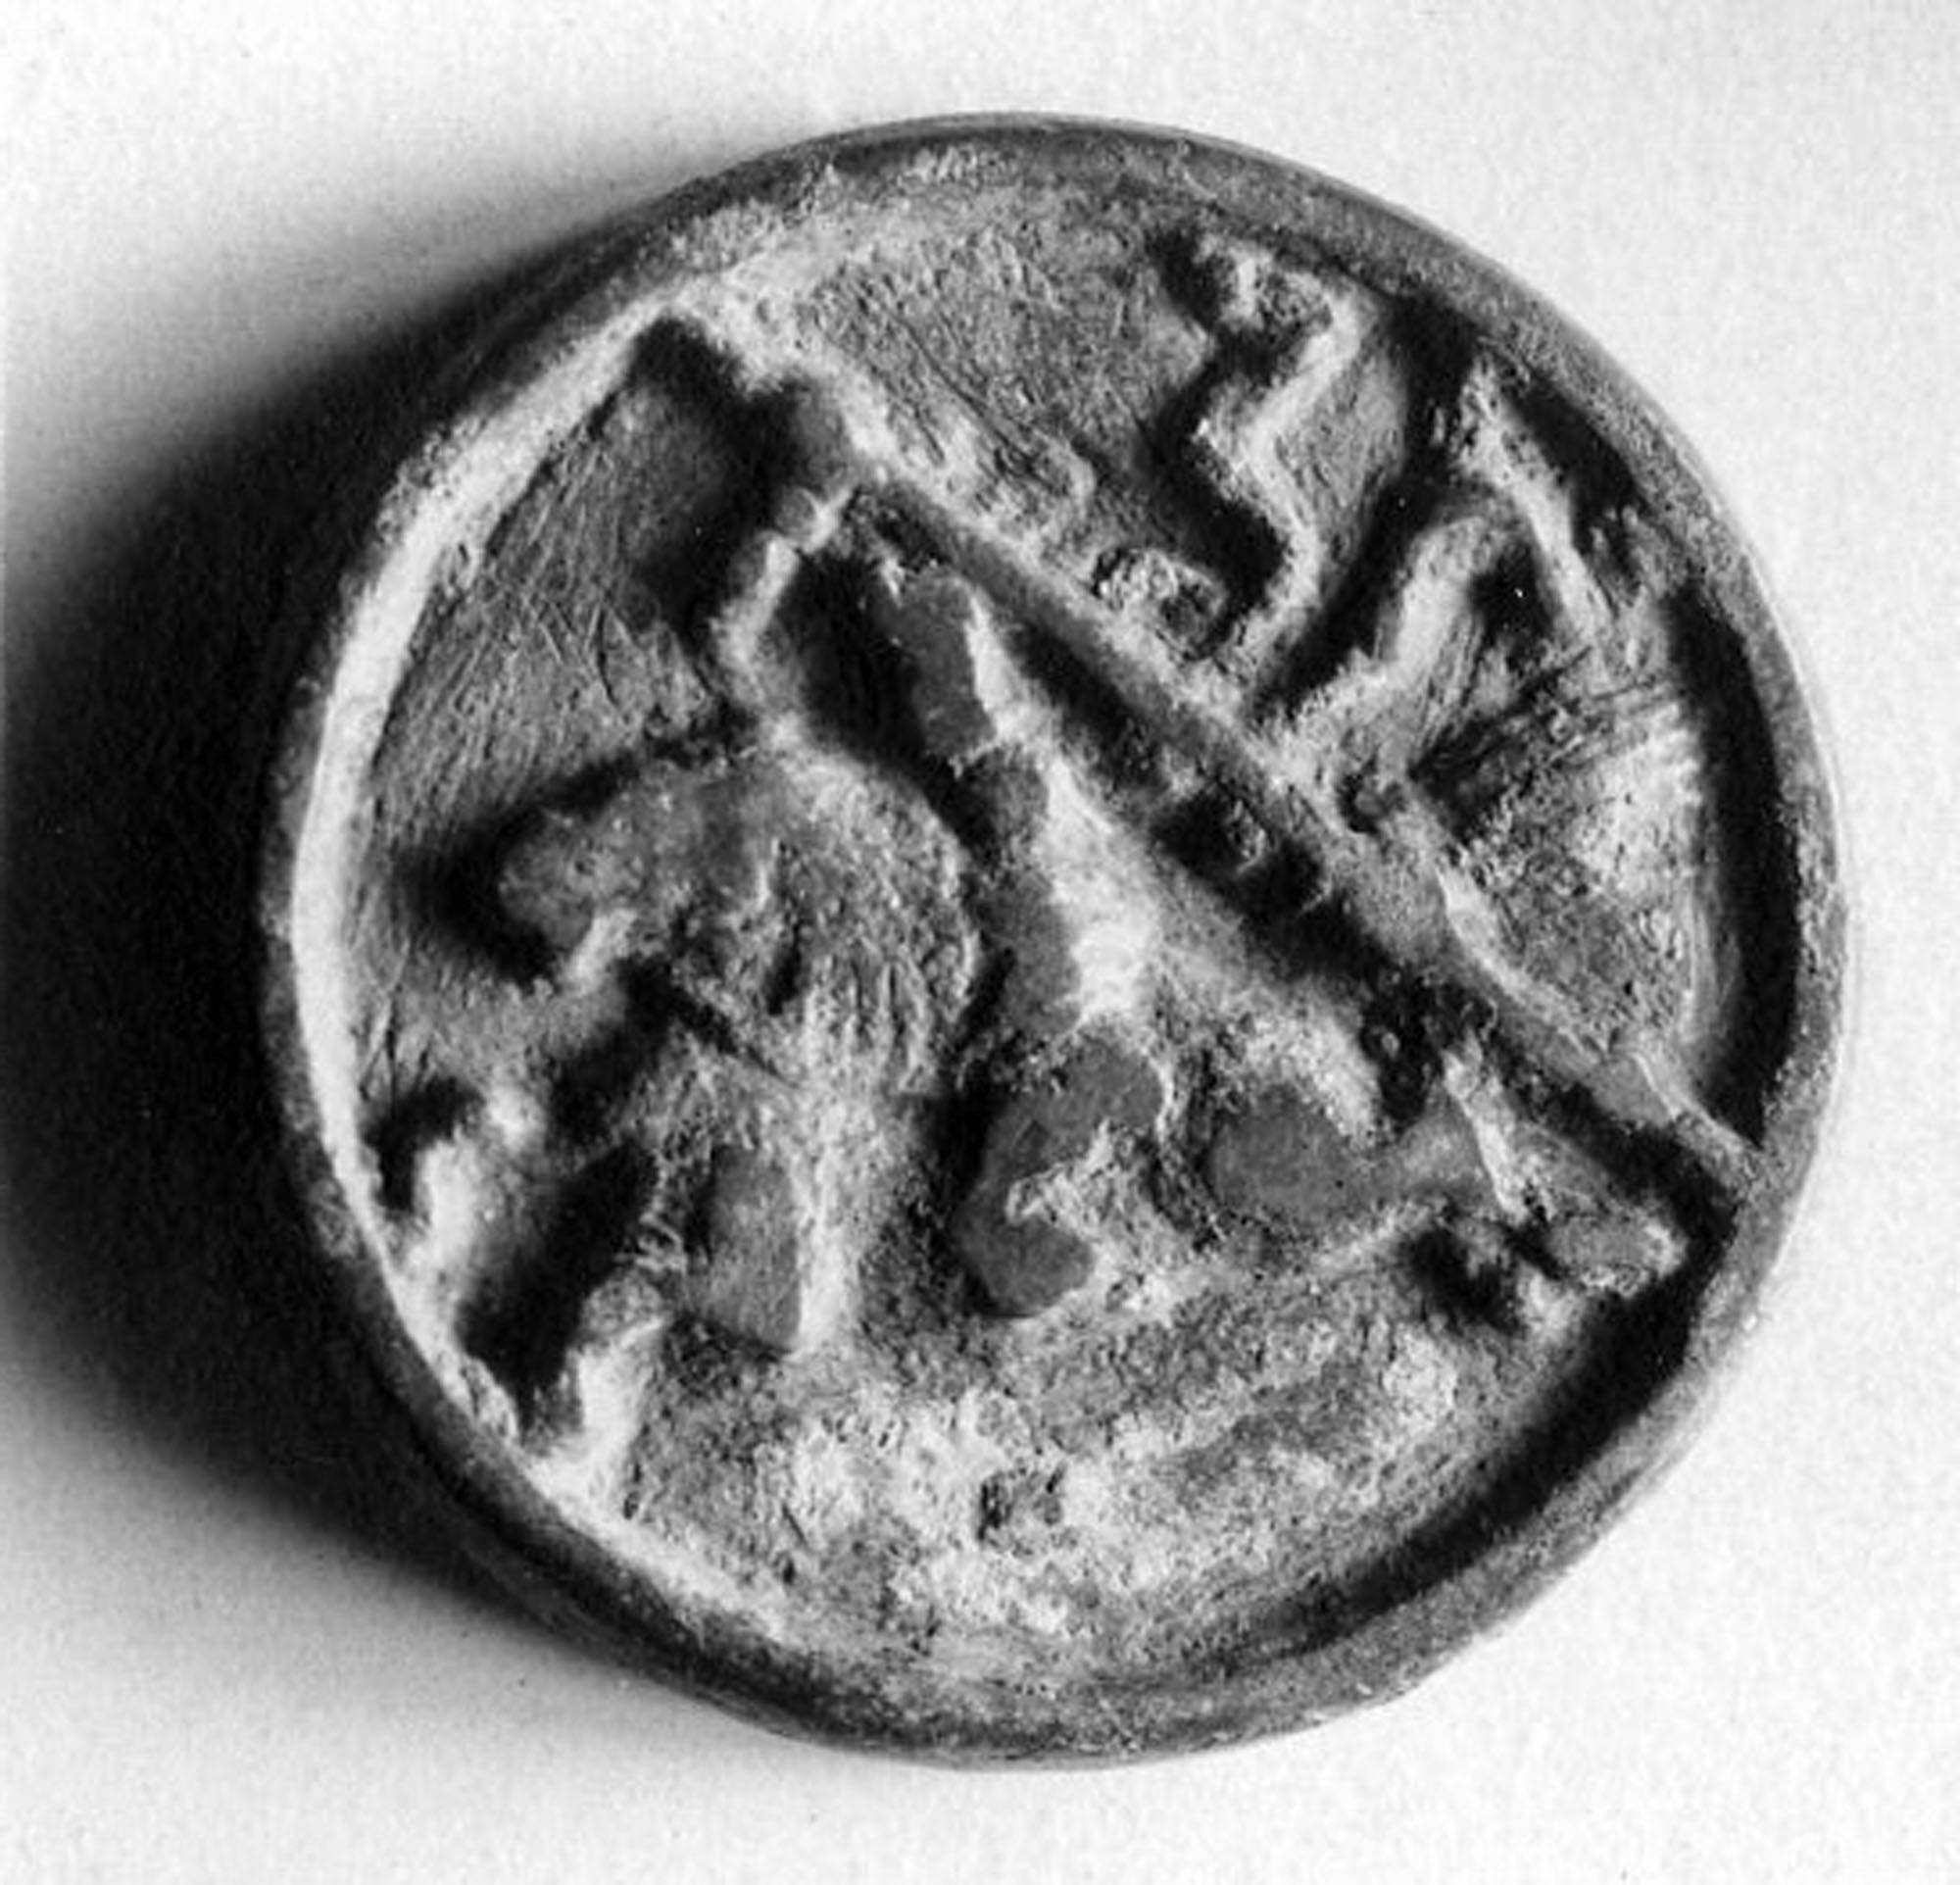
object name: belt plaque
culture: chinese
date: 201-600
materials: bronze